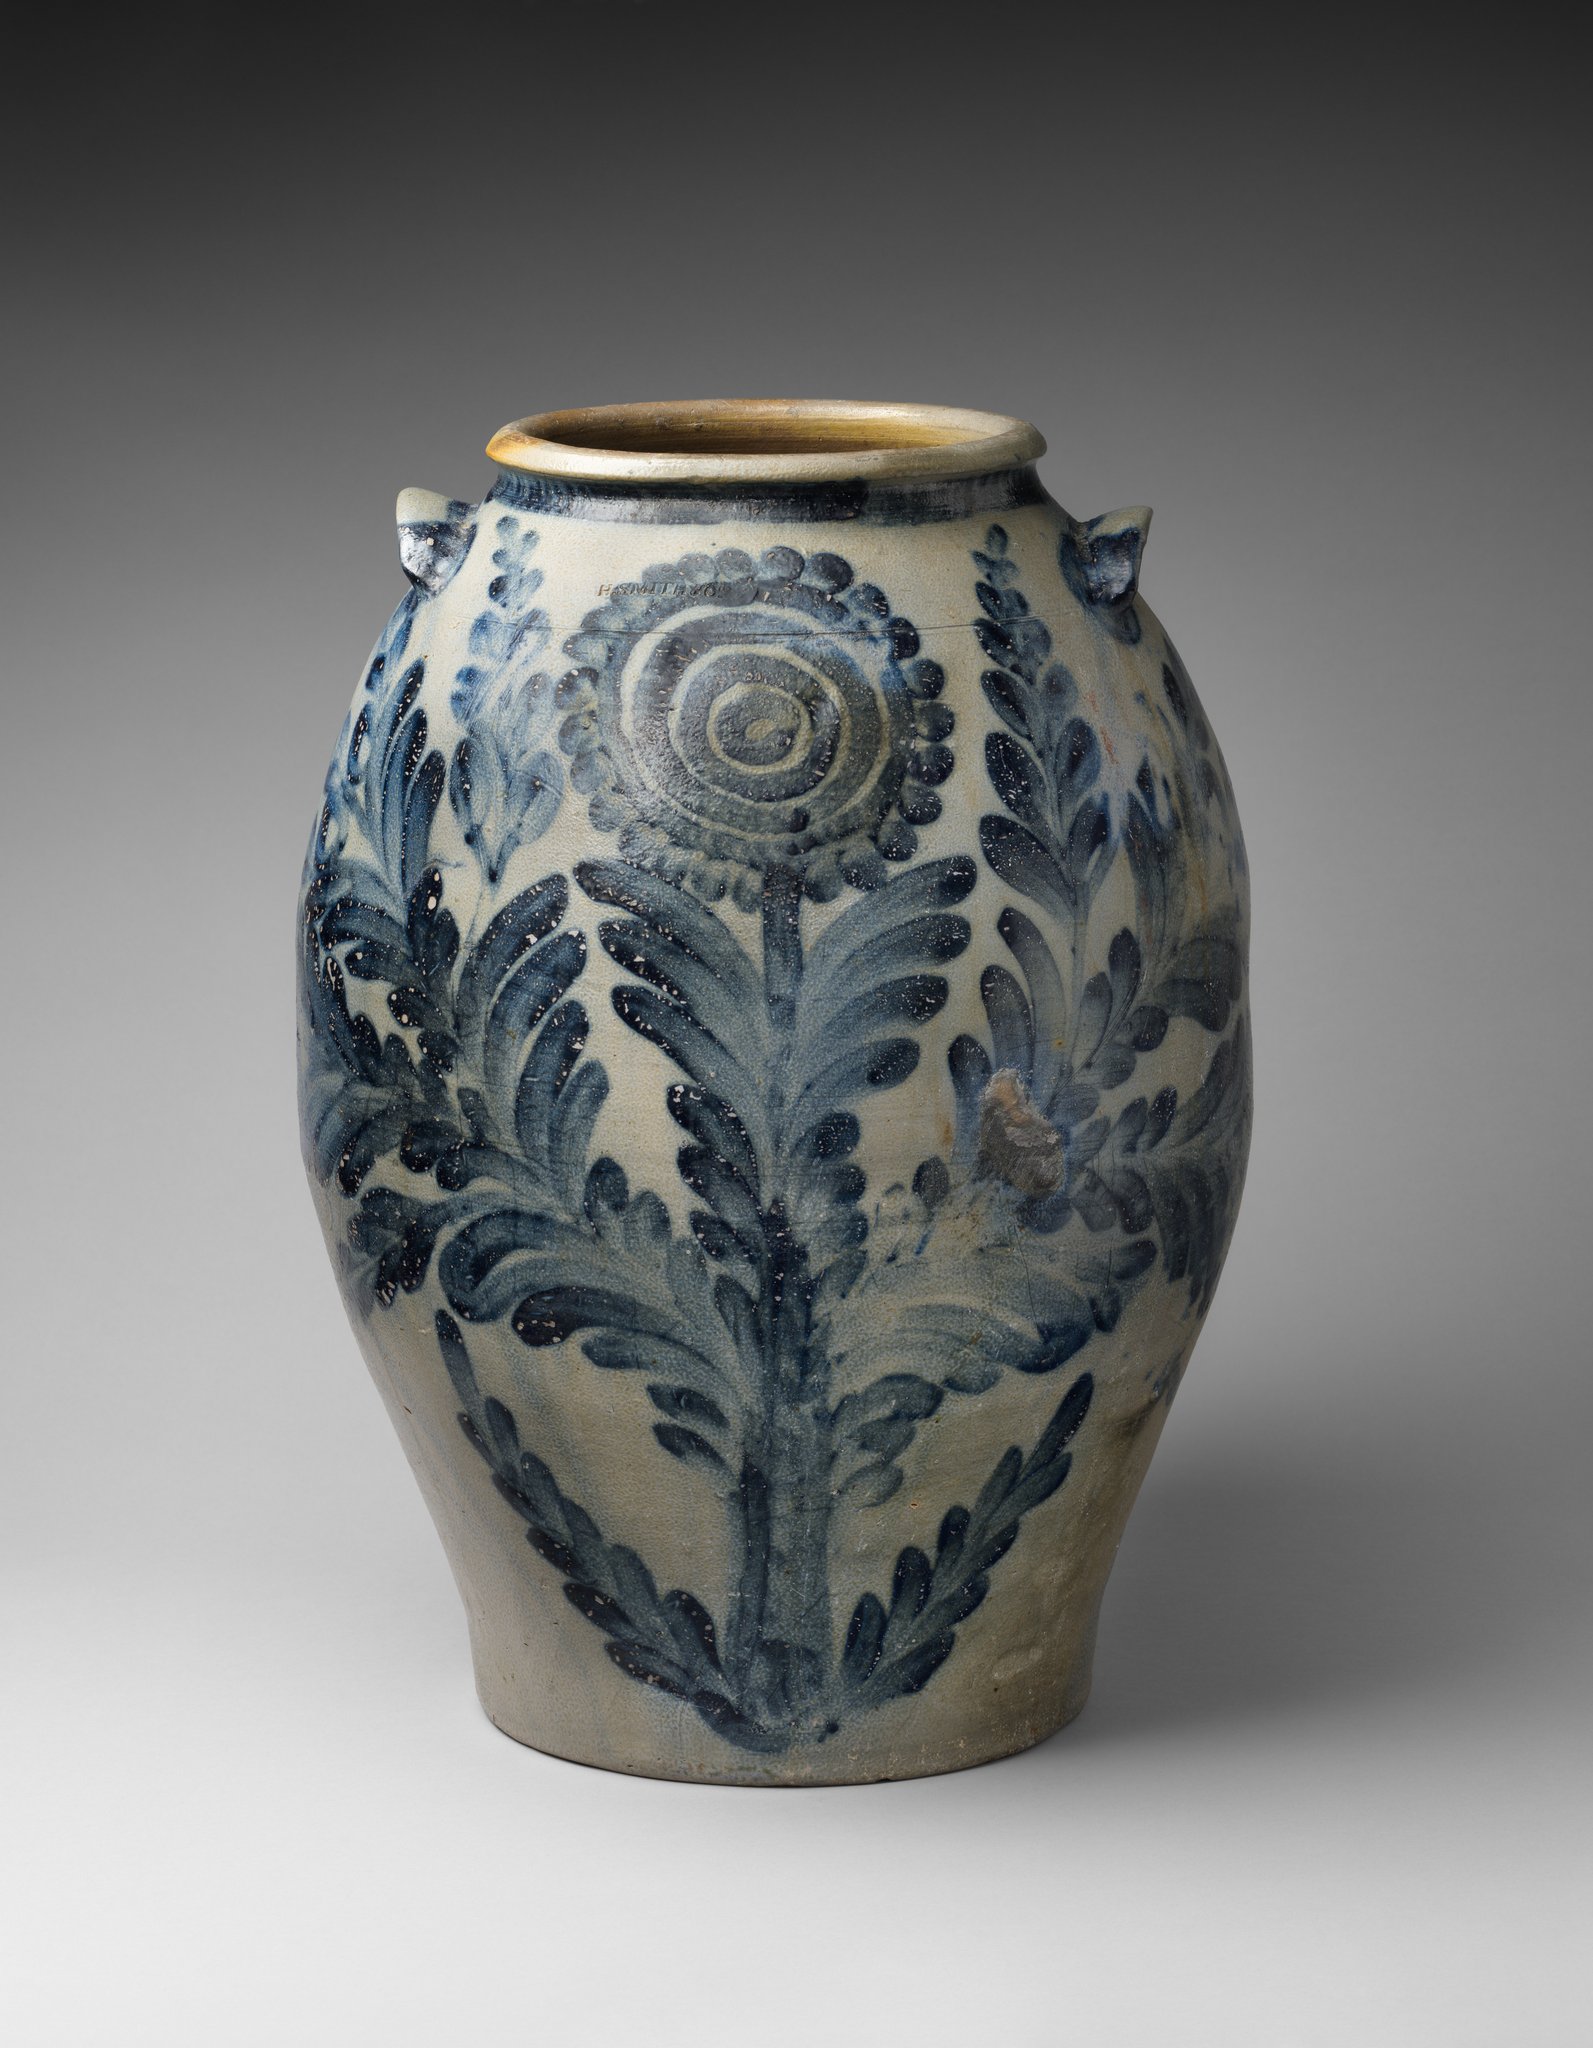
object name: storage jar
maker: david jarbour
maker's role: maker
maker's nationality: american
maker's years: 1780-1794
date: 1825-1831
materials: cobalt, stoneware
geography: united states